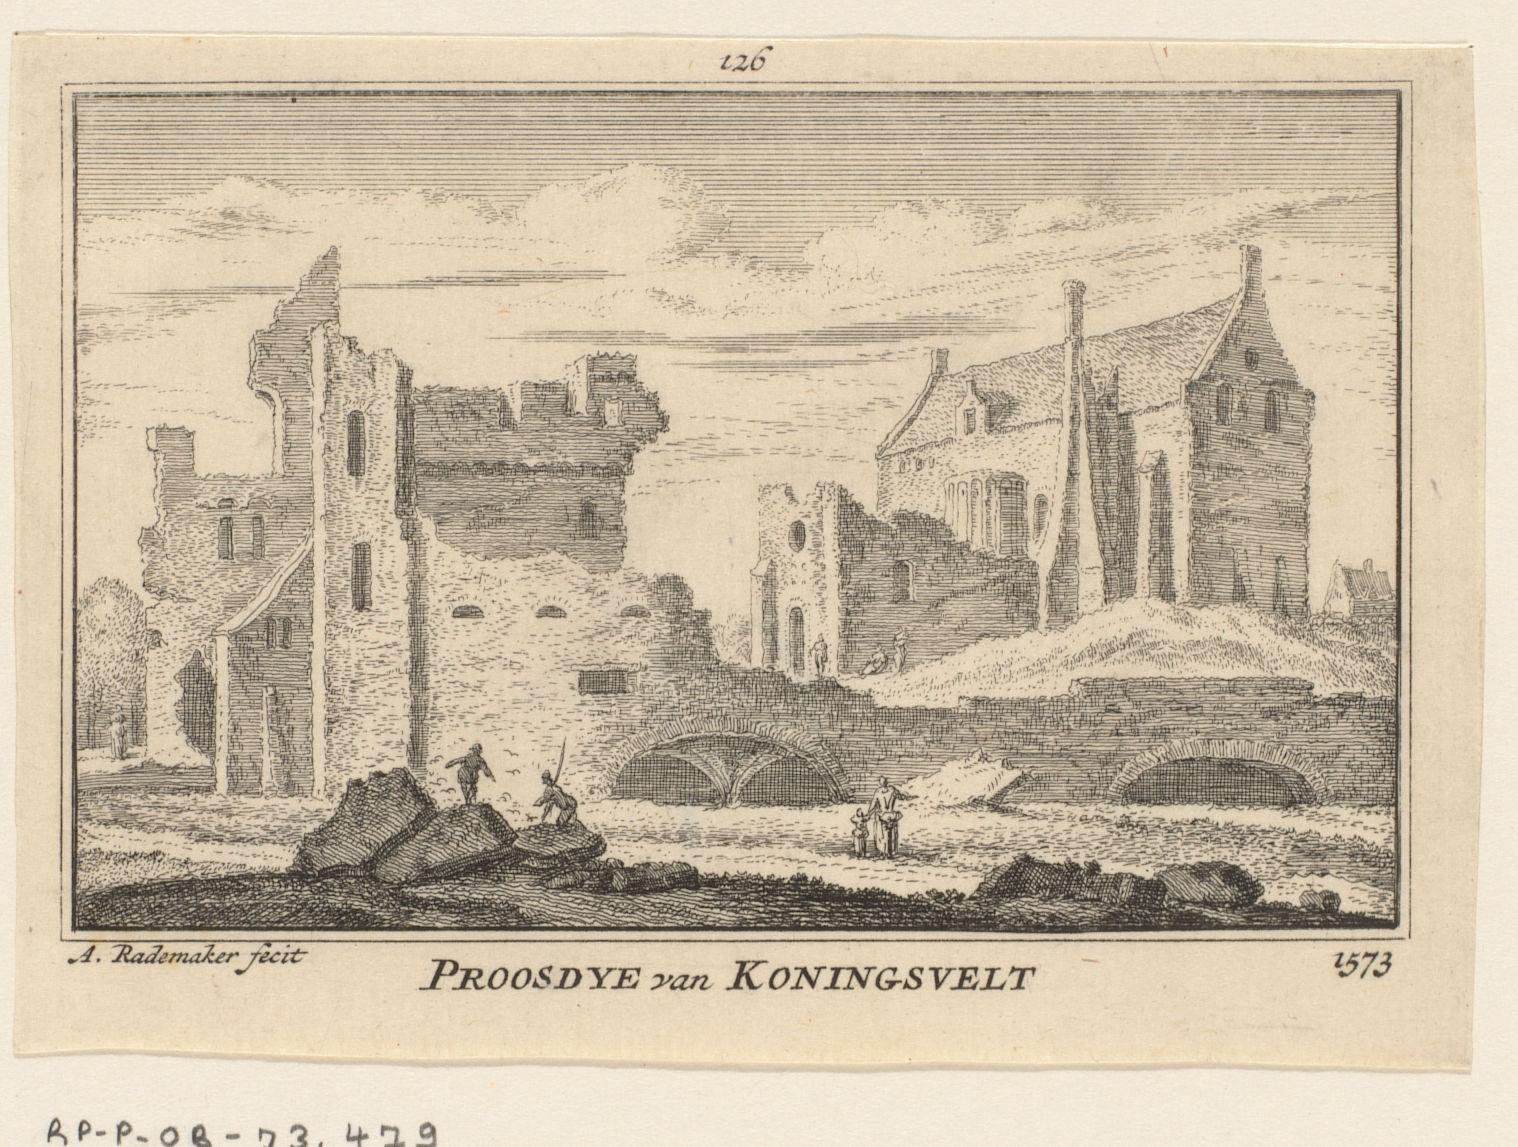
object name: print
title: Proosdye van Koningsvelt 1573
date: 1727-1733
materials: paper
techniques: etching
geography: amsterdam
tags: ruin of church, monastery, etc.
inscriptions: collector's mark: Lugt 2228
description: Illustratie uit: Abraham Rademaker, Matthaeus Brouërius van Niedek, Isaac Le Long, Kabinet van Nederlandsche en Kleefsche outheden en (...) voorname stads- en landgebouwen, Willem Barents en Antoni Schoonenburg: Amsterdam, 1727-1733, ill. nr. 126.